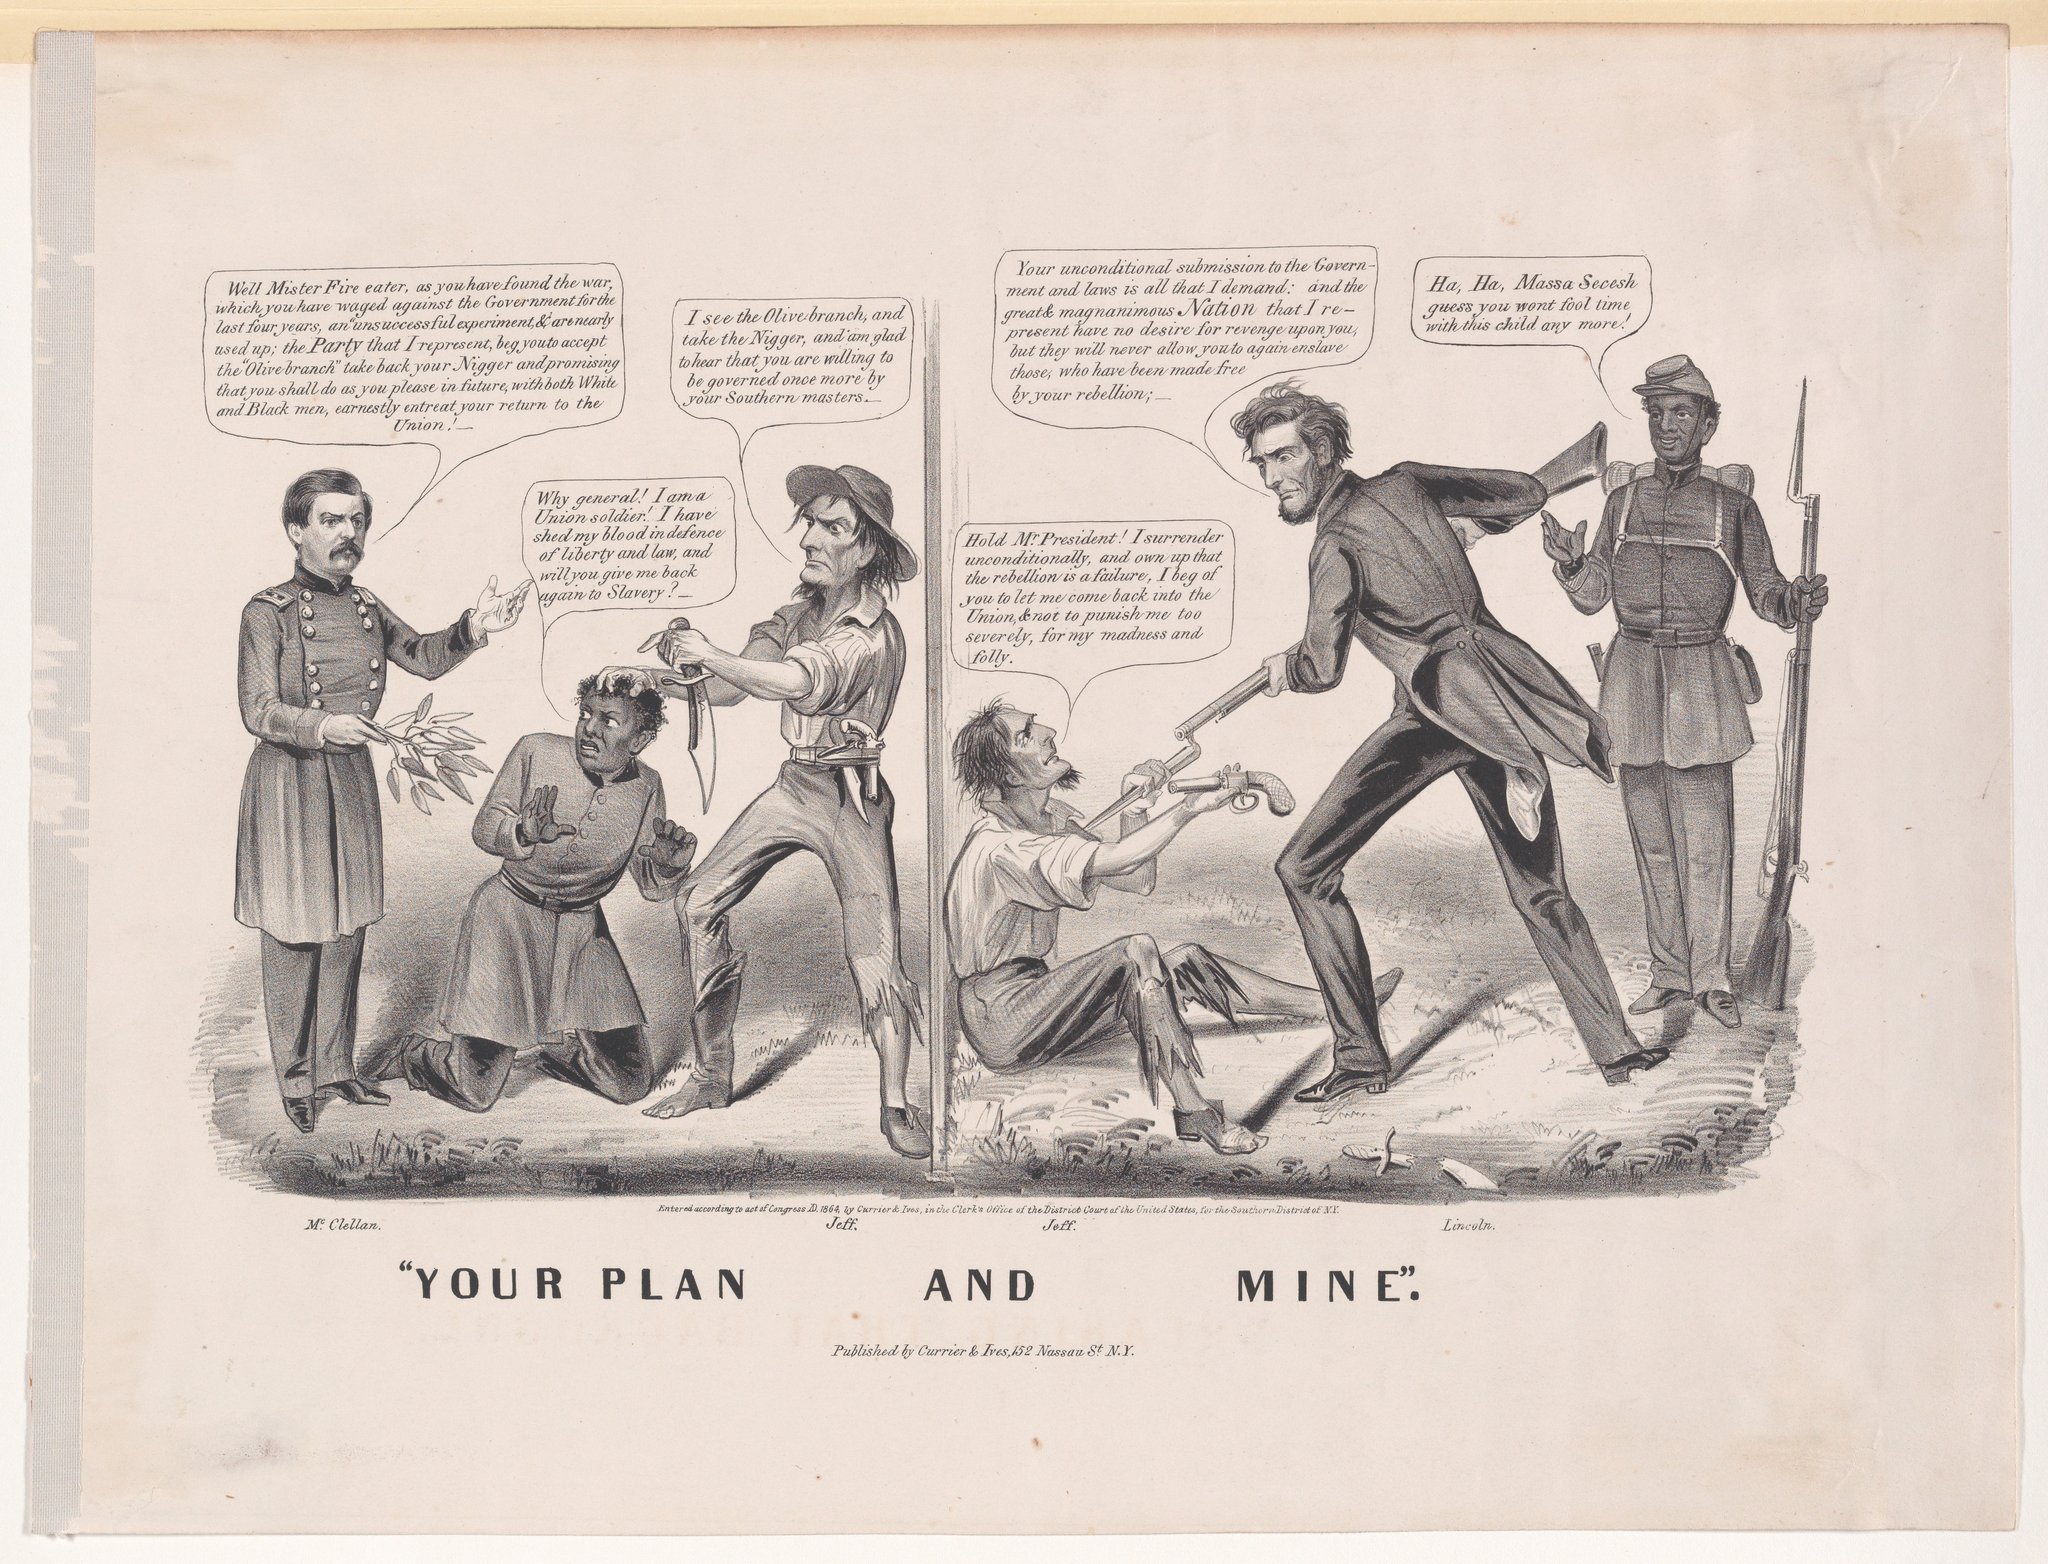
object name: print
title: "Your Plan and Mine"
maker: currier & ives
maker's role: publisher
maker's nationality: american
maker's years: 1857-1907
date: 1864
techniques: lithograph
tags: satire,american civil war,abraham lincoln,politics